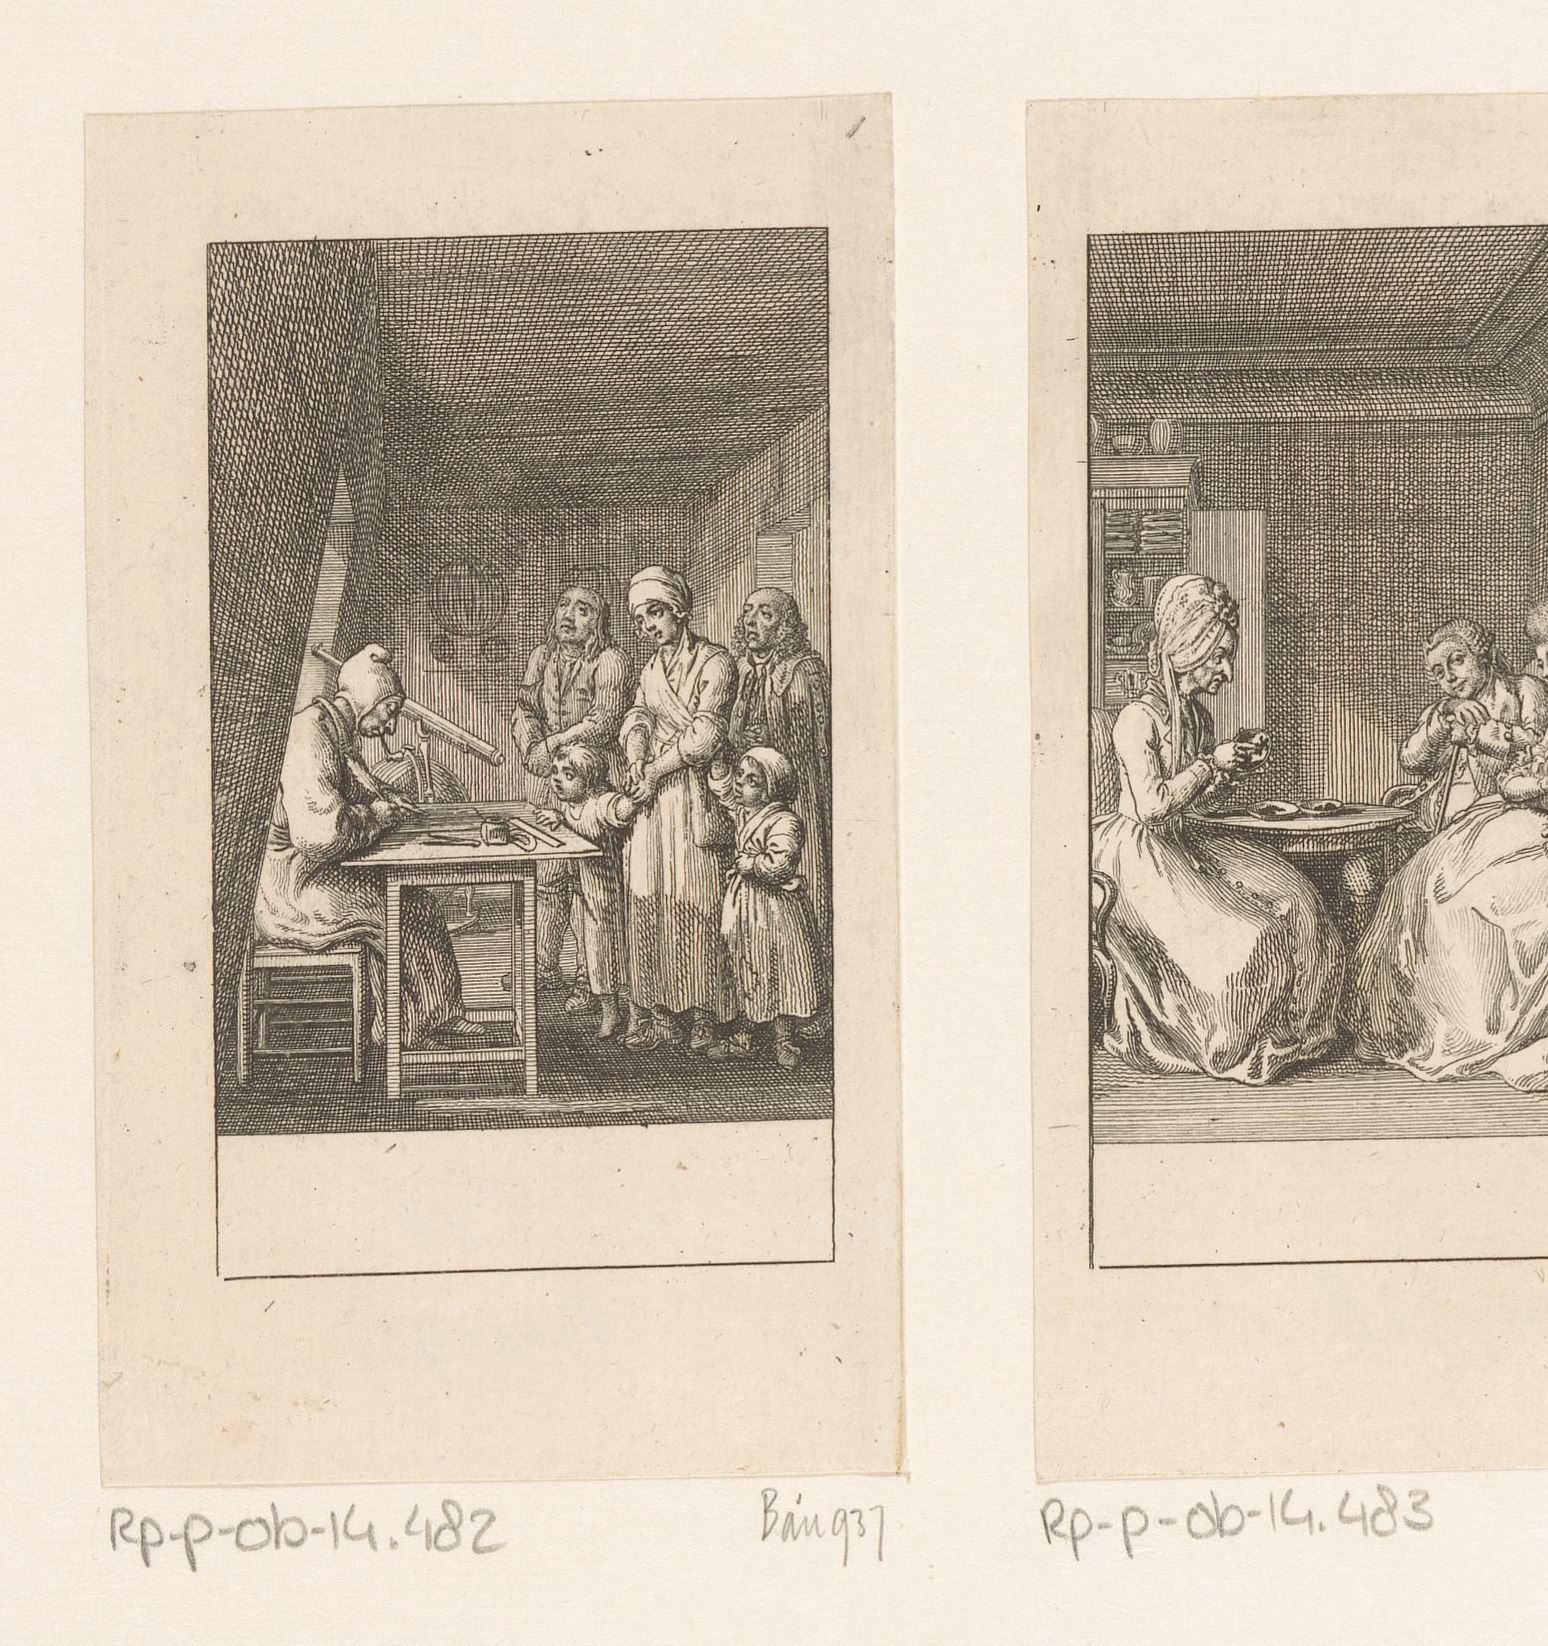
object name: print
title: Dwaasheid van de astrologie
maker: daniel nikolaus chodowiecki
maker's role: draughtsman, print maker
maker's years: 1726-1801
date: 1782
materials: paper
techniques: etching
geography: berlin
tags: horoscope, astrologer at work, telescope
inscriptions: collector's mark: Lugt 2228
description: Vervaardigd voor Sancta Clara's 'Centifolium Stultorum'. Latere staat gebruikt voor: Goettinger Taschen Calender vom Jahr 1783. bey Joh. Chr. Dietrich. Göttingen: Georg Christoph Lichtenberg, 1782.